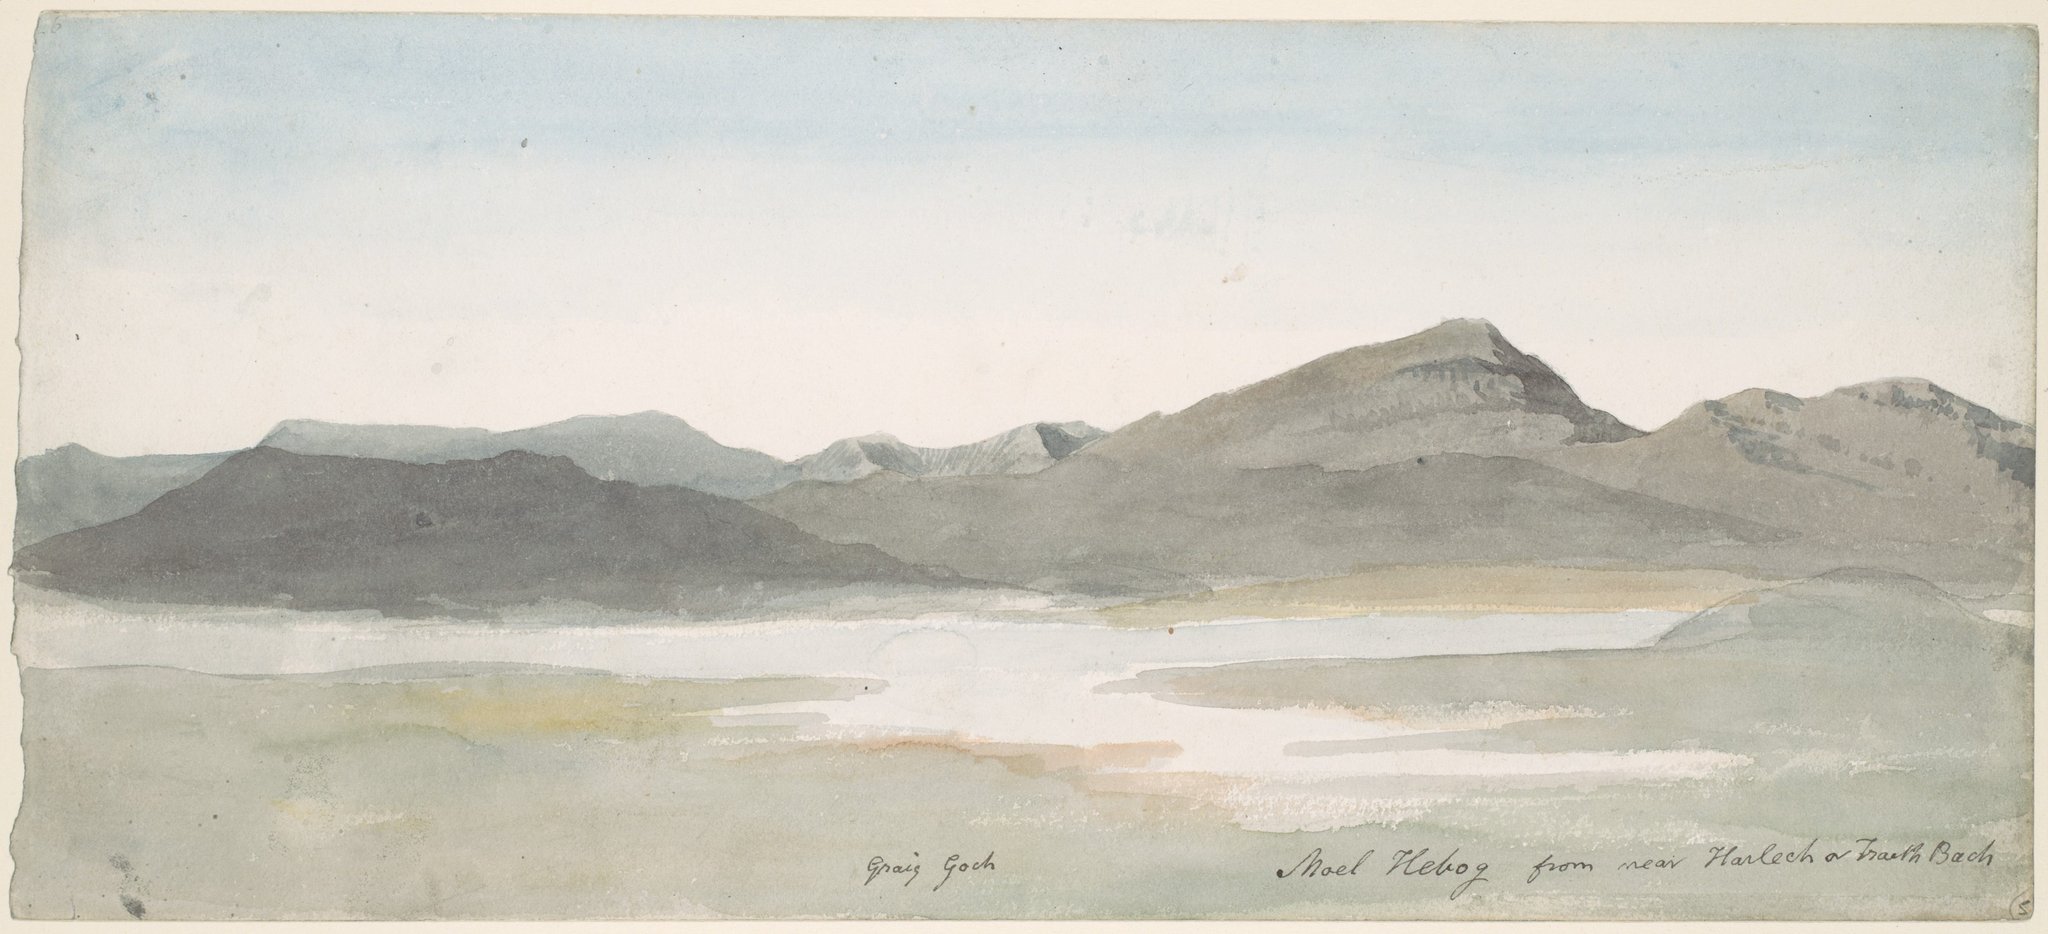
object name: drawing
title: Craig Goch, Moel Hebog, North Wales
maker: cornelius varley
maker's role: artist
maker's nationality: british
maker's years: 1781-1873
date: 1802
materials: graphite, watercolor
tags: landscapes